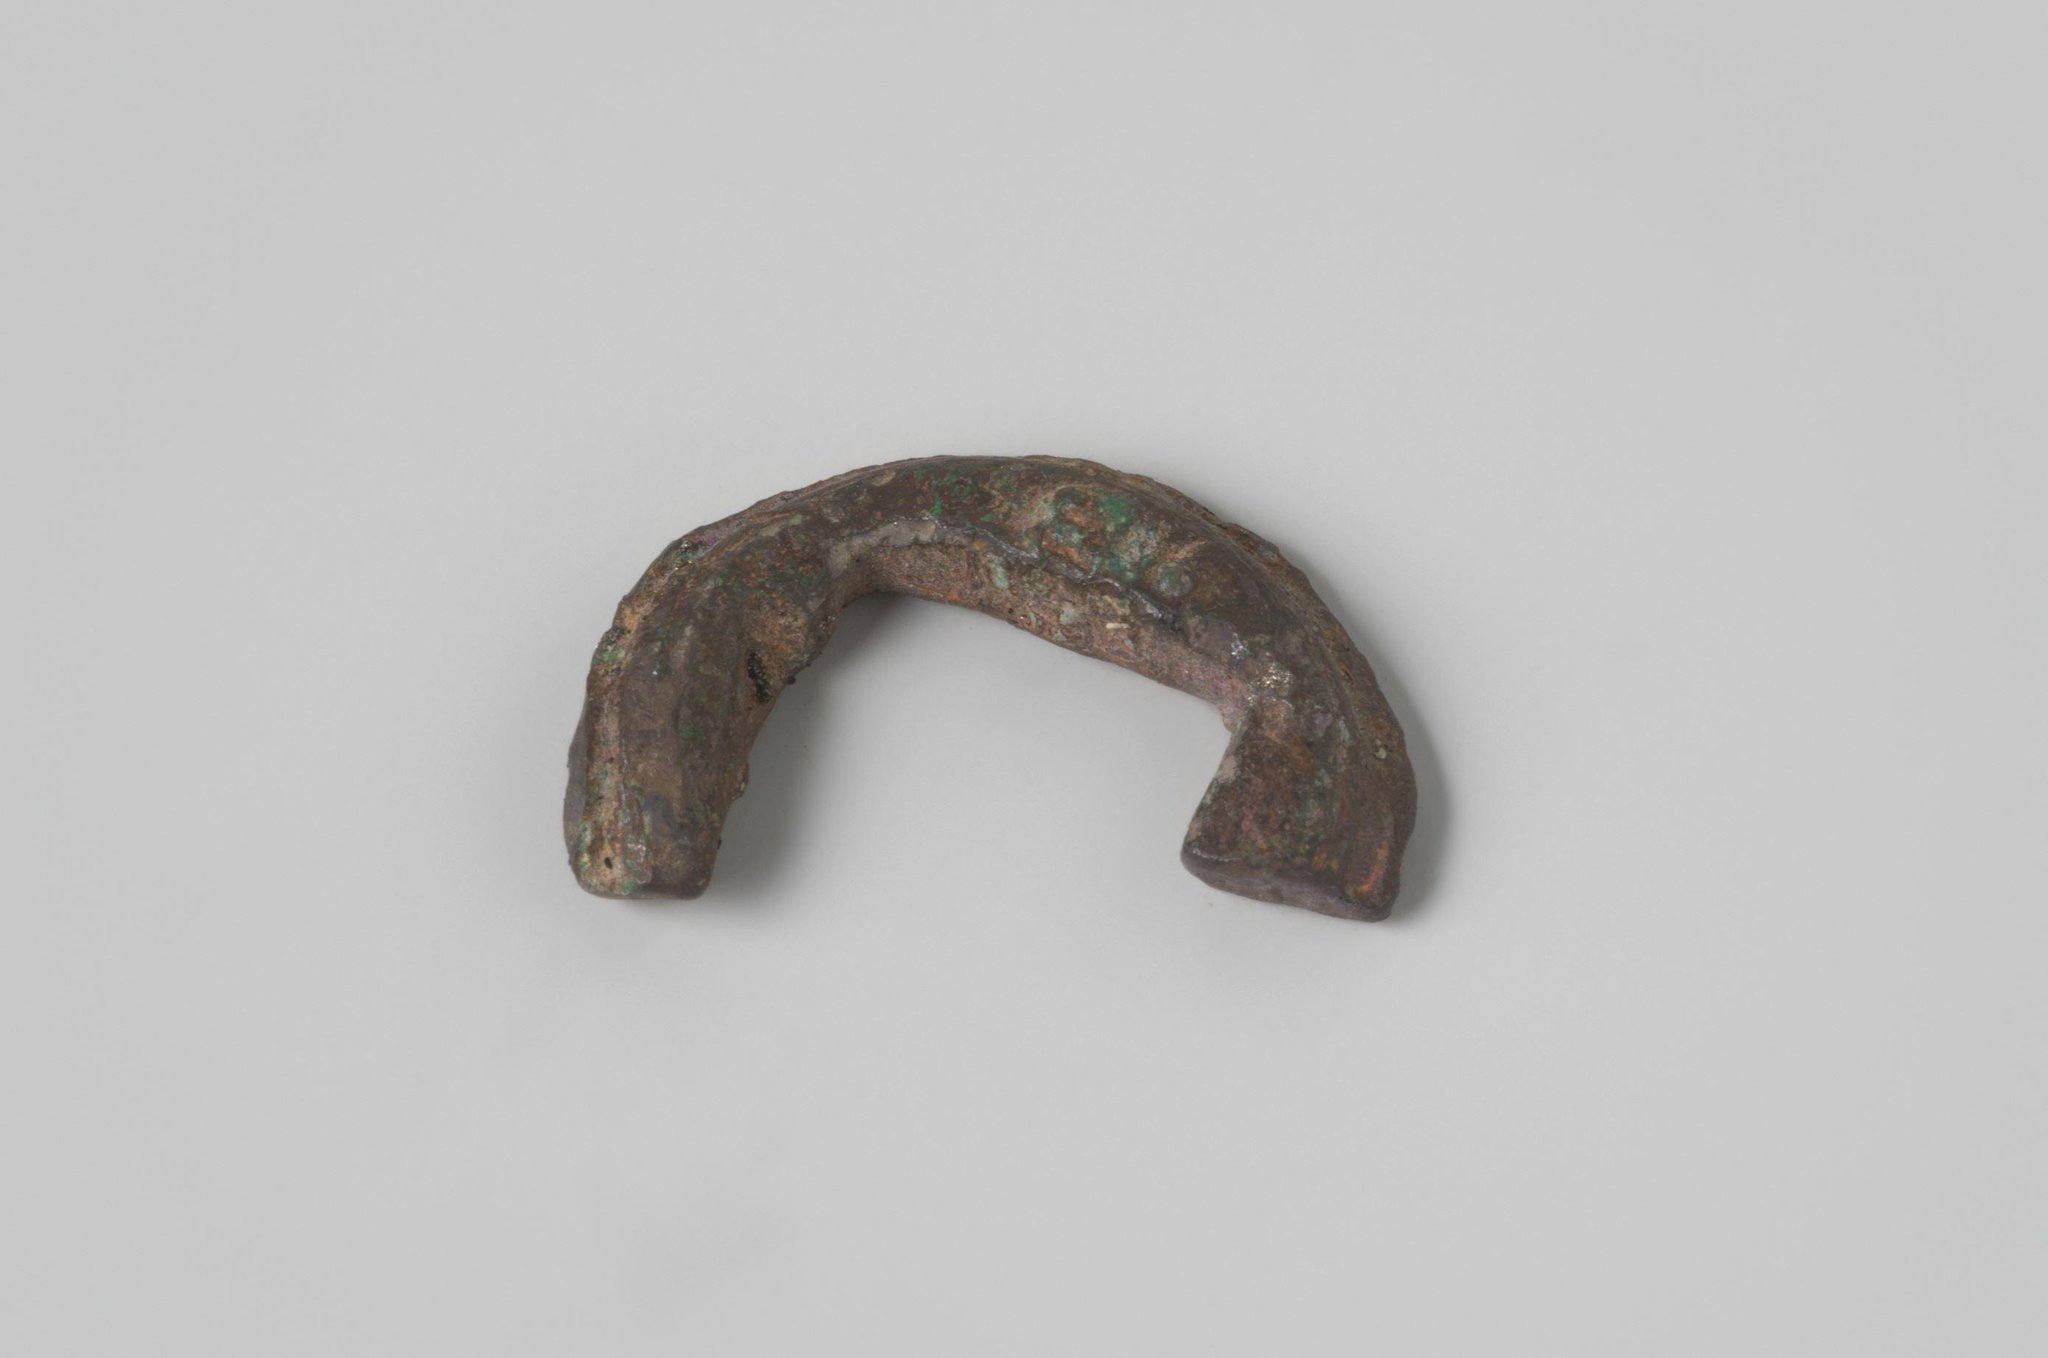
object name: hilt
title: Fragment sluitring van een gevest uit het wrak van de Oost-Indiëvaarder Hollandia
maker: Anonymous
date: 1700-1743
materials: silver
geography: netherlands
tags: verenigde oostindische compagnie, hollandia (schip), annet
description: Hilt, washer fragm, sim. NG 1980-27H651.